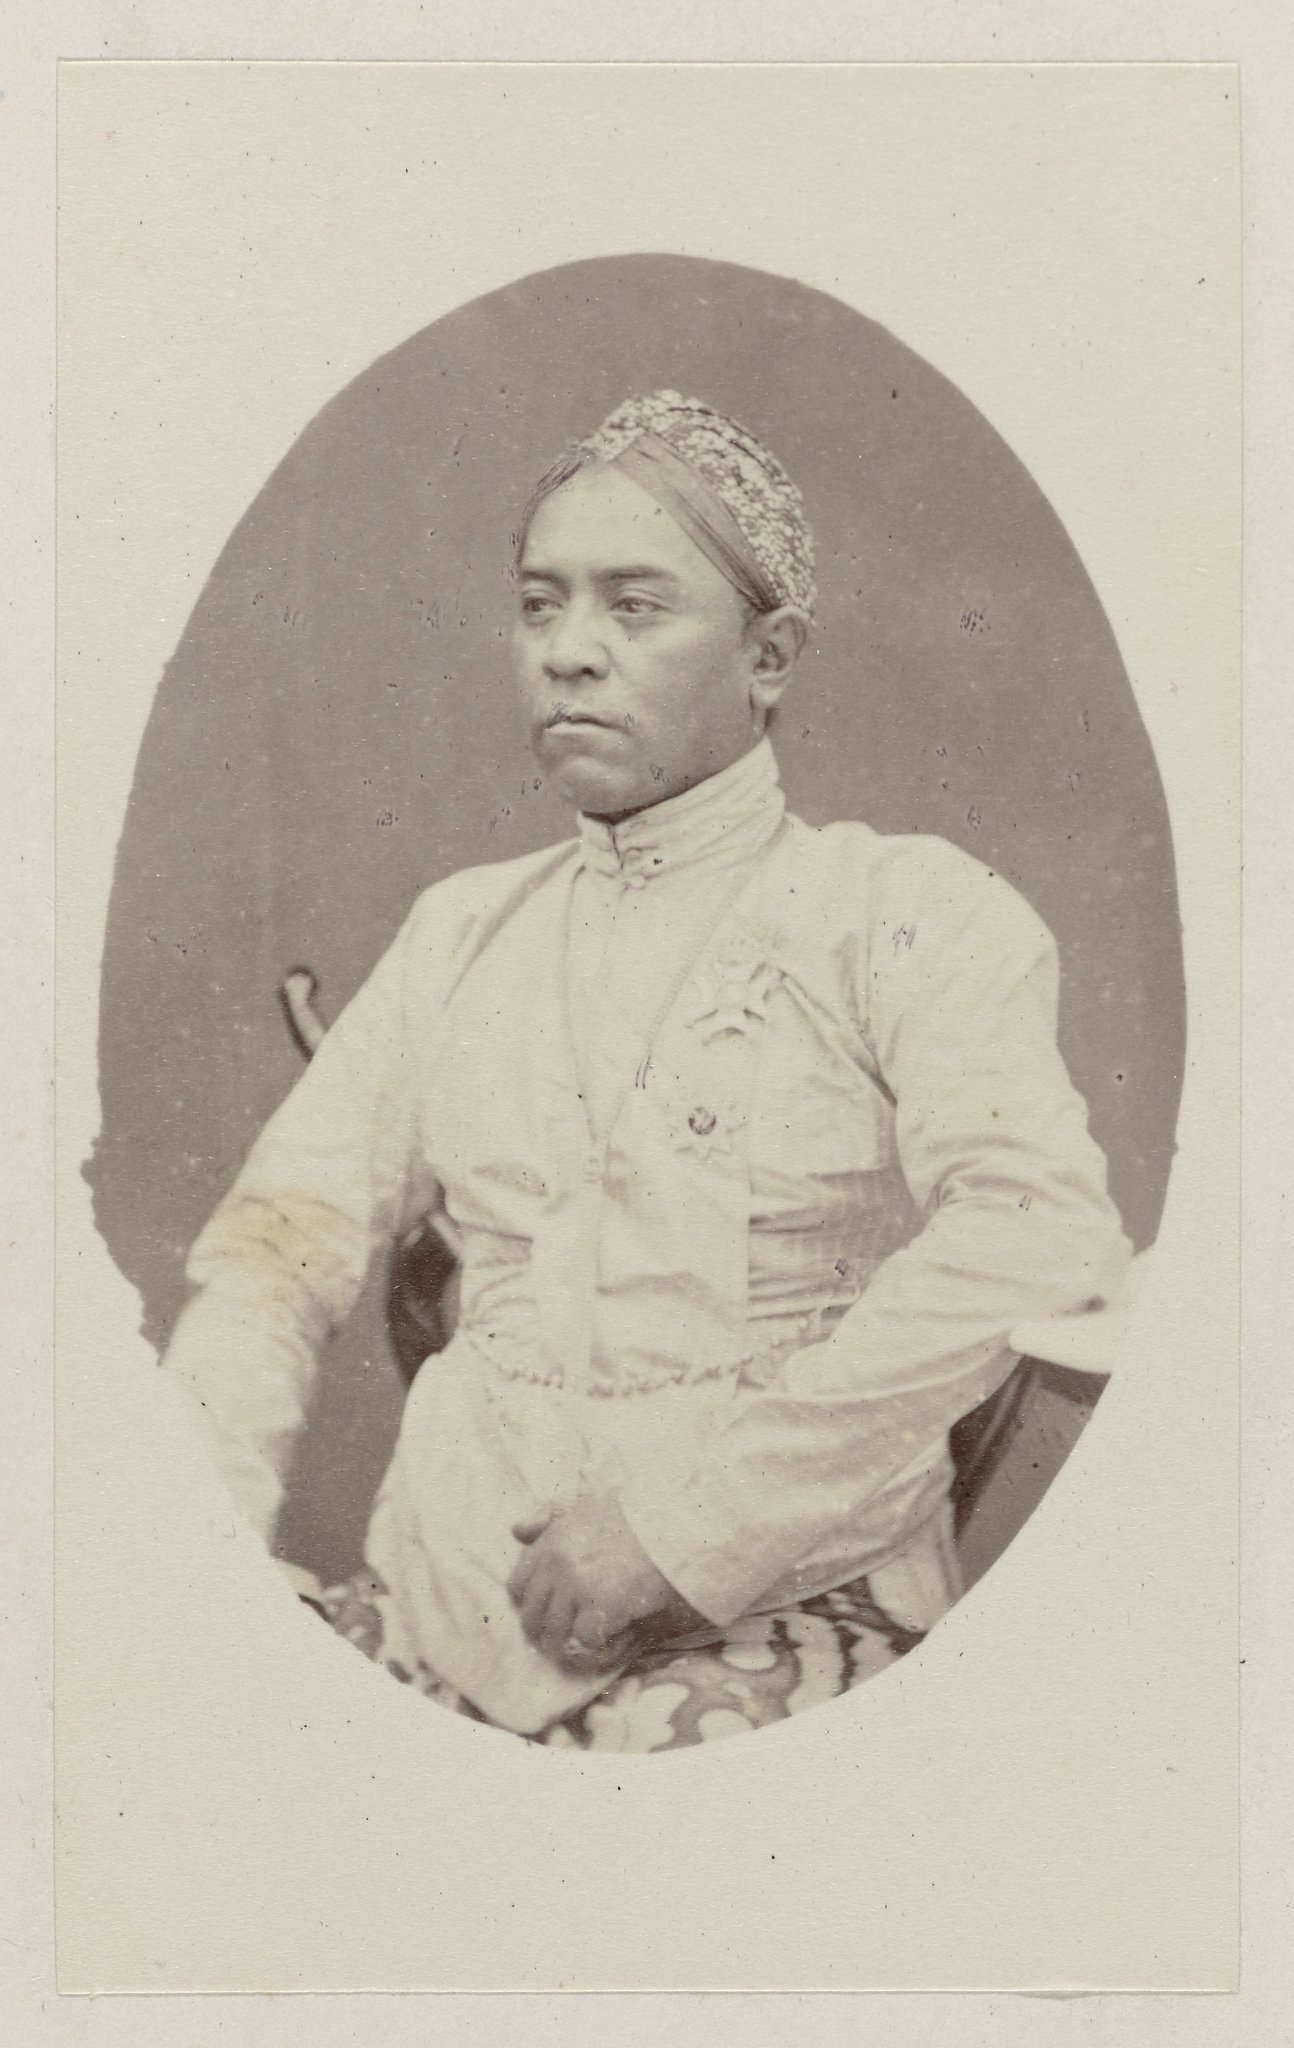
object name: photograph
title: Hamengku Buwono VIII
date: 1865-1890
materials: photographic support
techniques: albumen print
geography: batavia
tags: historical persons, ruler, sovereign, java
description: Ovaal studioportret van Hamengku Buwono VIII, sultan van Jogyakarta. Ingeplakte foto in het fotoalbum getiteld: Gezichten van Java.